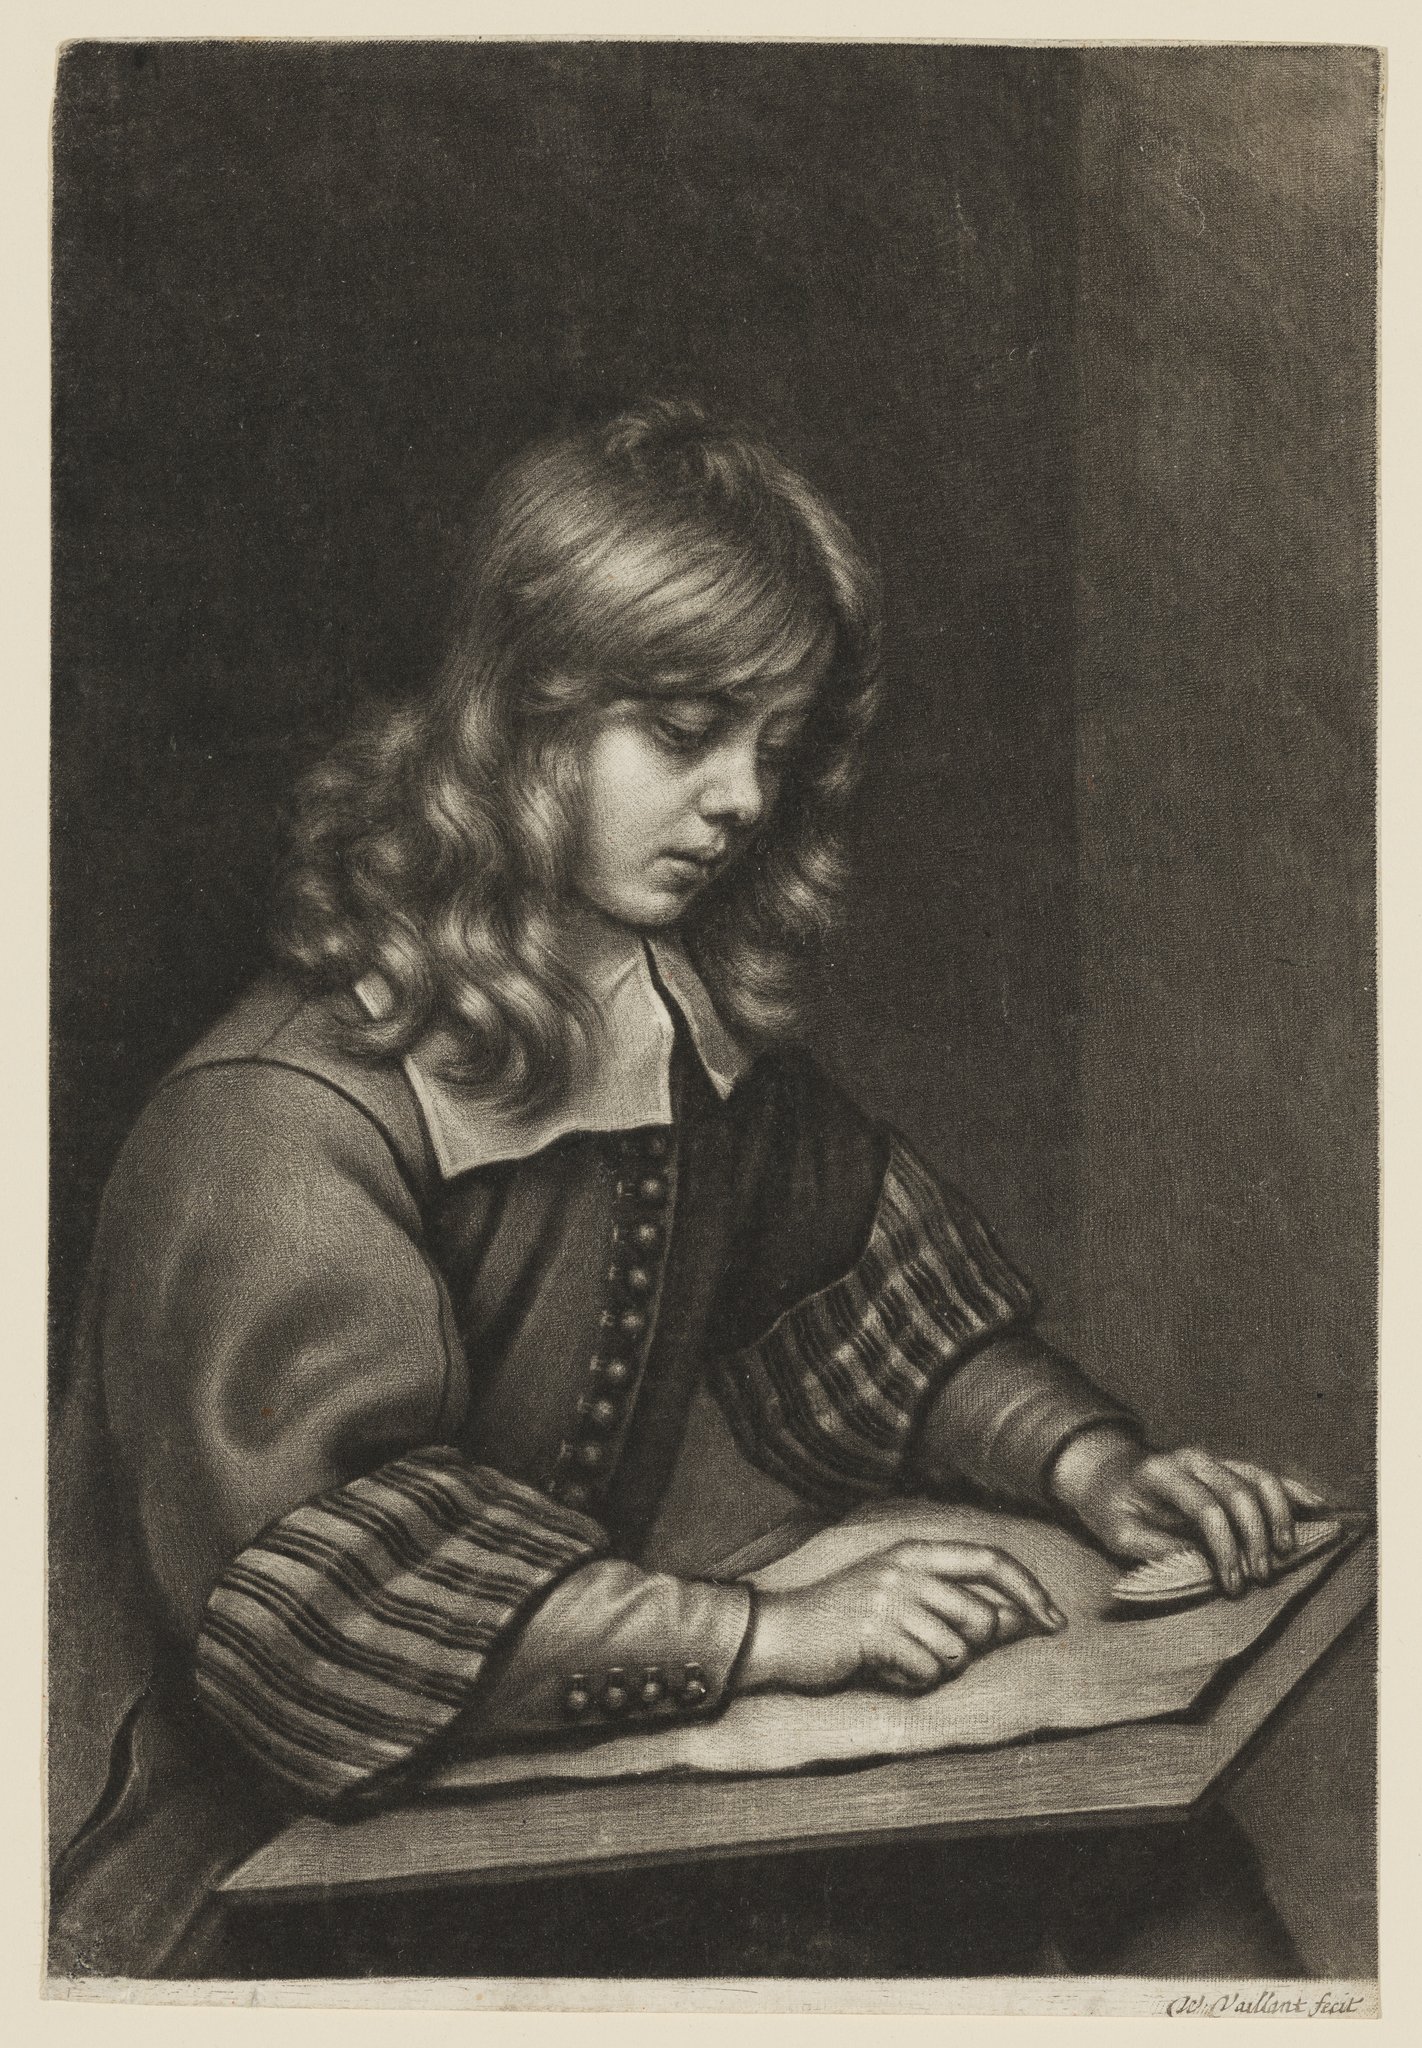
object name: print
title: Boy with a Drawing Board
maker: wallerant vaillant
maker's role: artist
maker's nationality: dutch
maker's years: 1623-1677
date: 1601-1700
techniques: mezzotint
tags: boys